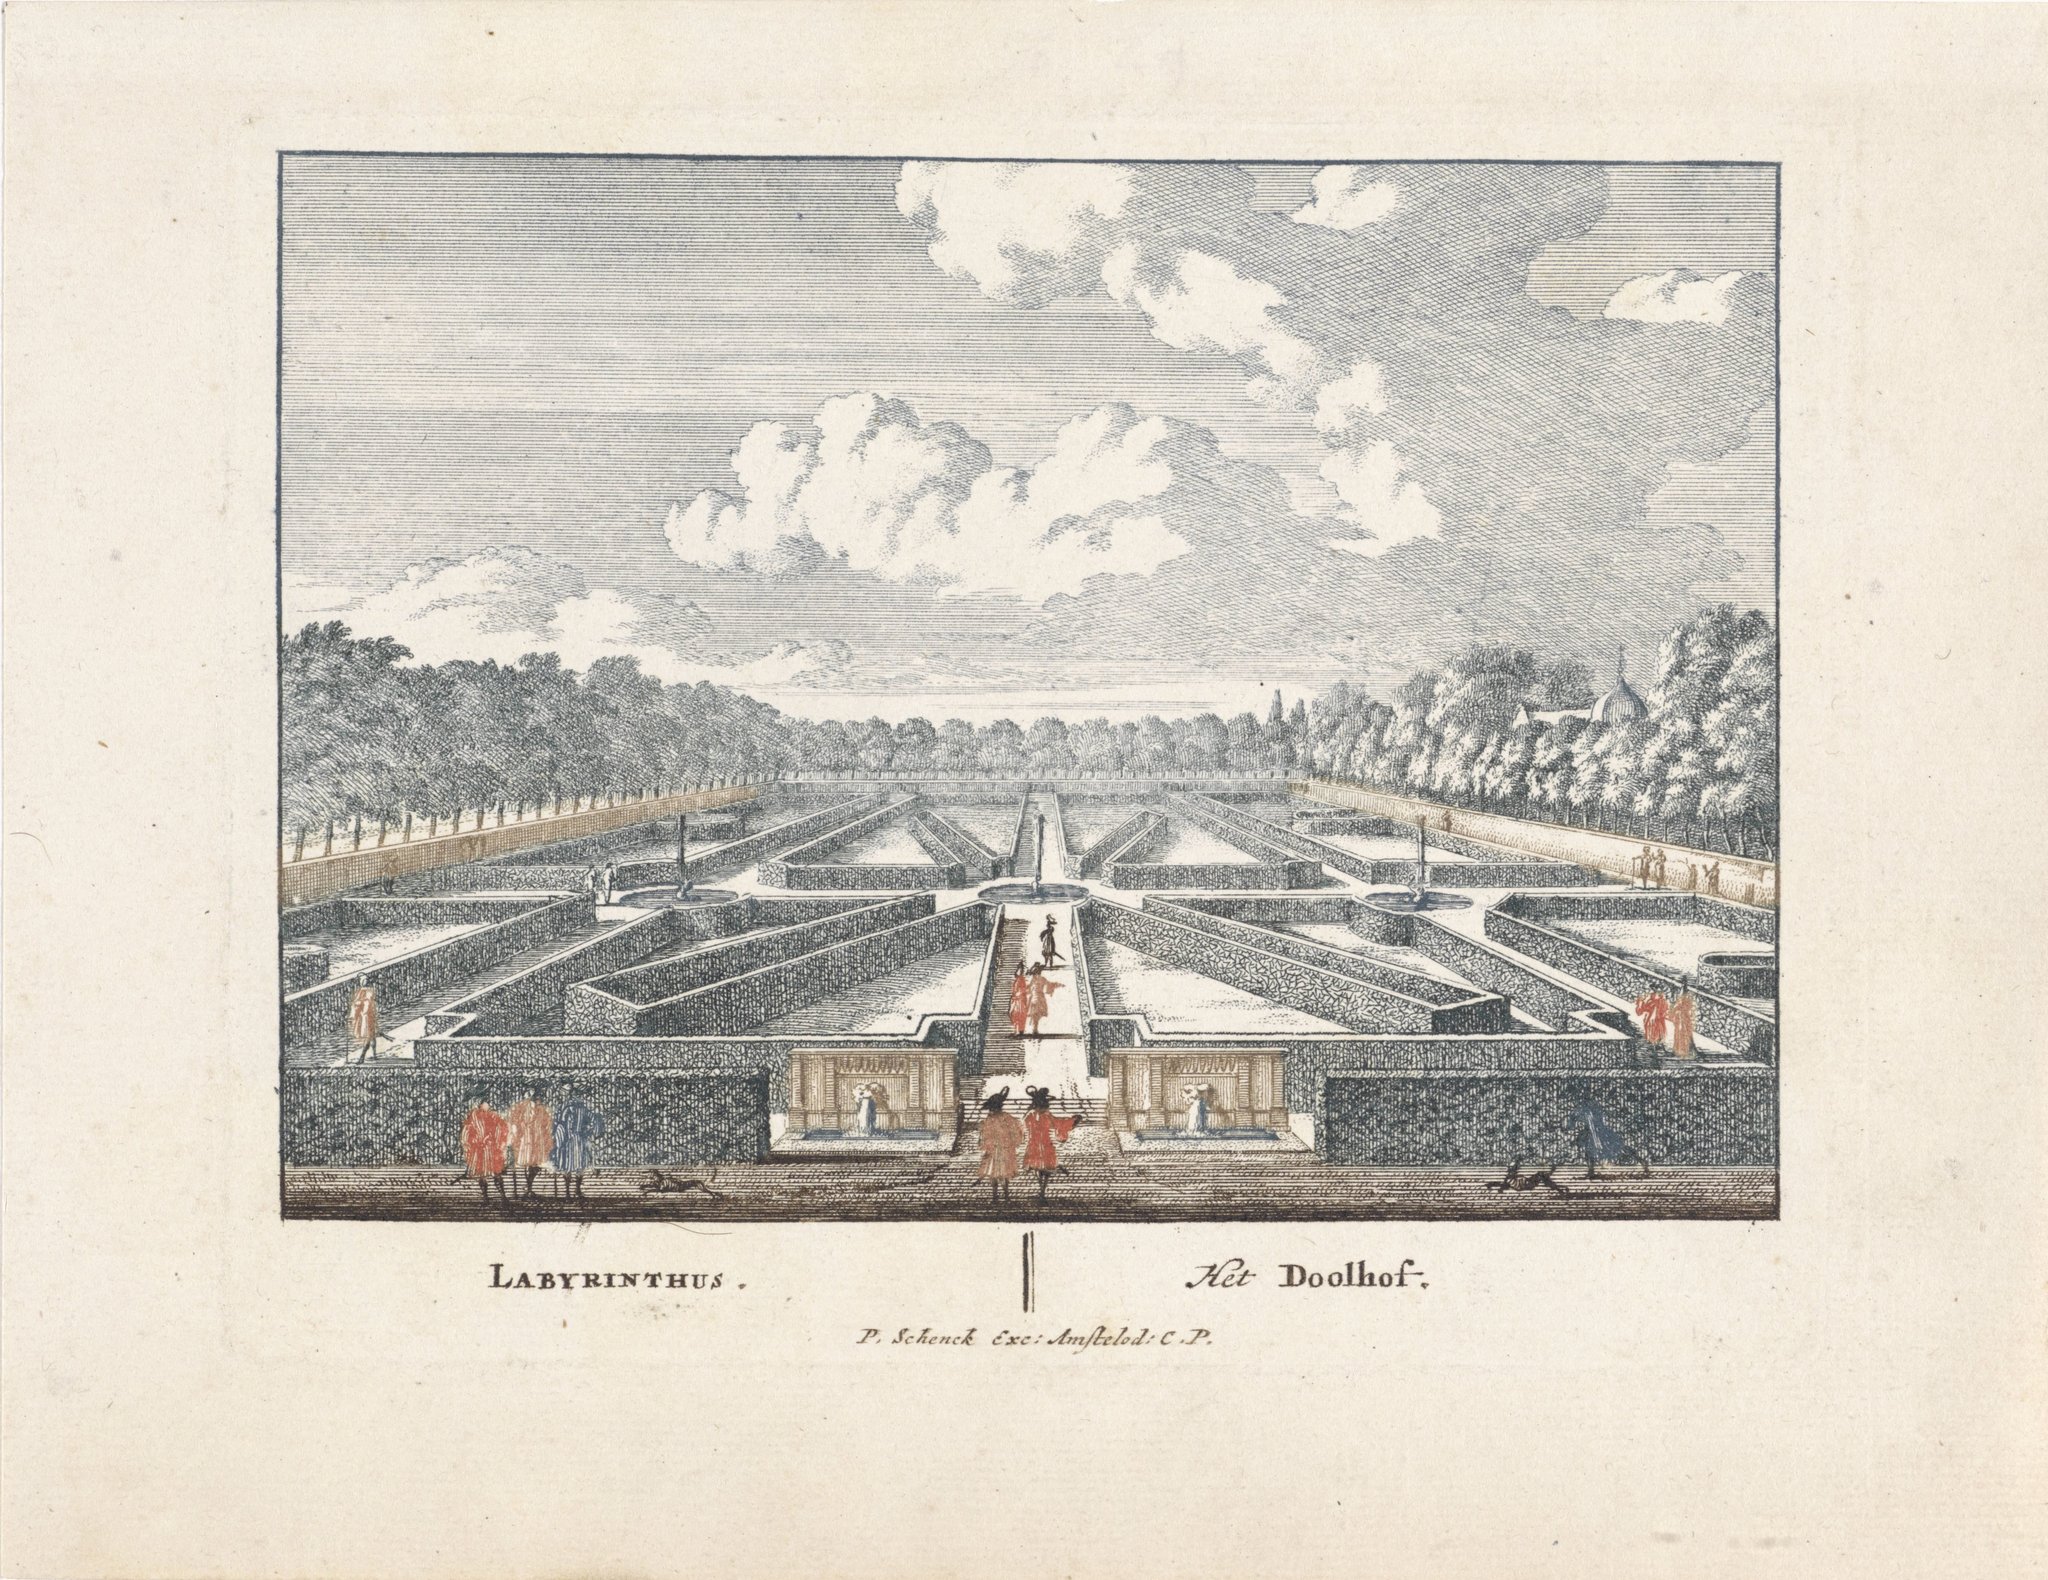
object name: print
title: Admirandorum quadruplex spectaculum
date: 1694-1697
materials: paper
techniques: etching, hand coloring, lithography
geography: amsterdam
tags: french or architectonic garden; formal garden, labyrinth, maze ~ garden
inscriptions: collector's mark: Lugt 2228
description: Prent uit een serie van 71 prenten met Rijnlandschappen, gezichten op vorstelijke paleizen en stadsgezichten uit Den Haag en Amsterdam.